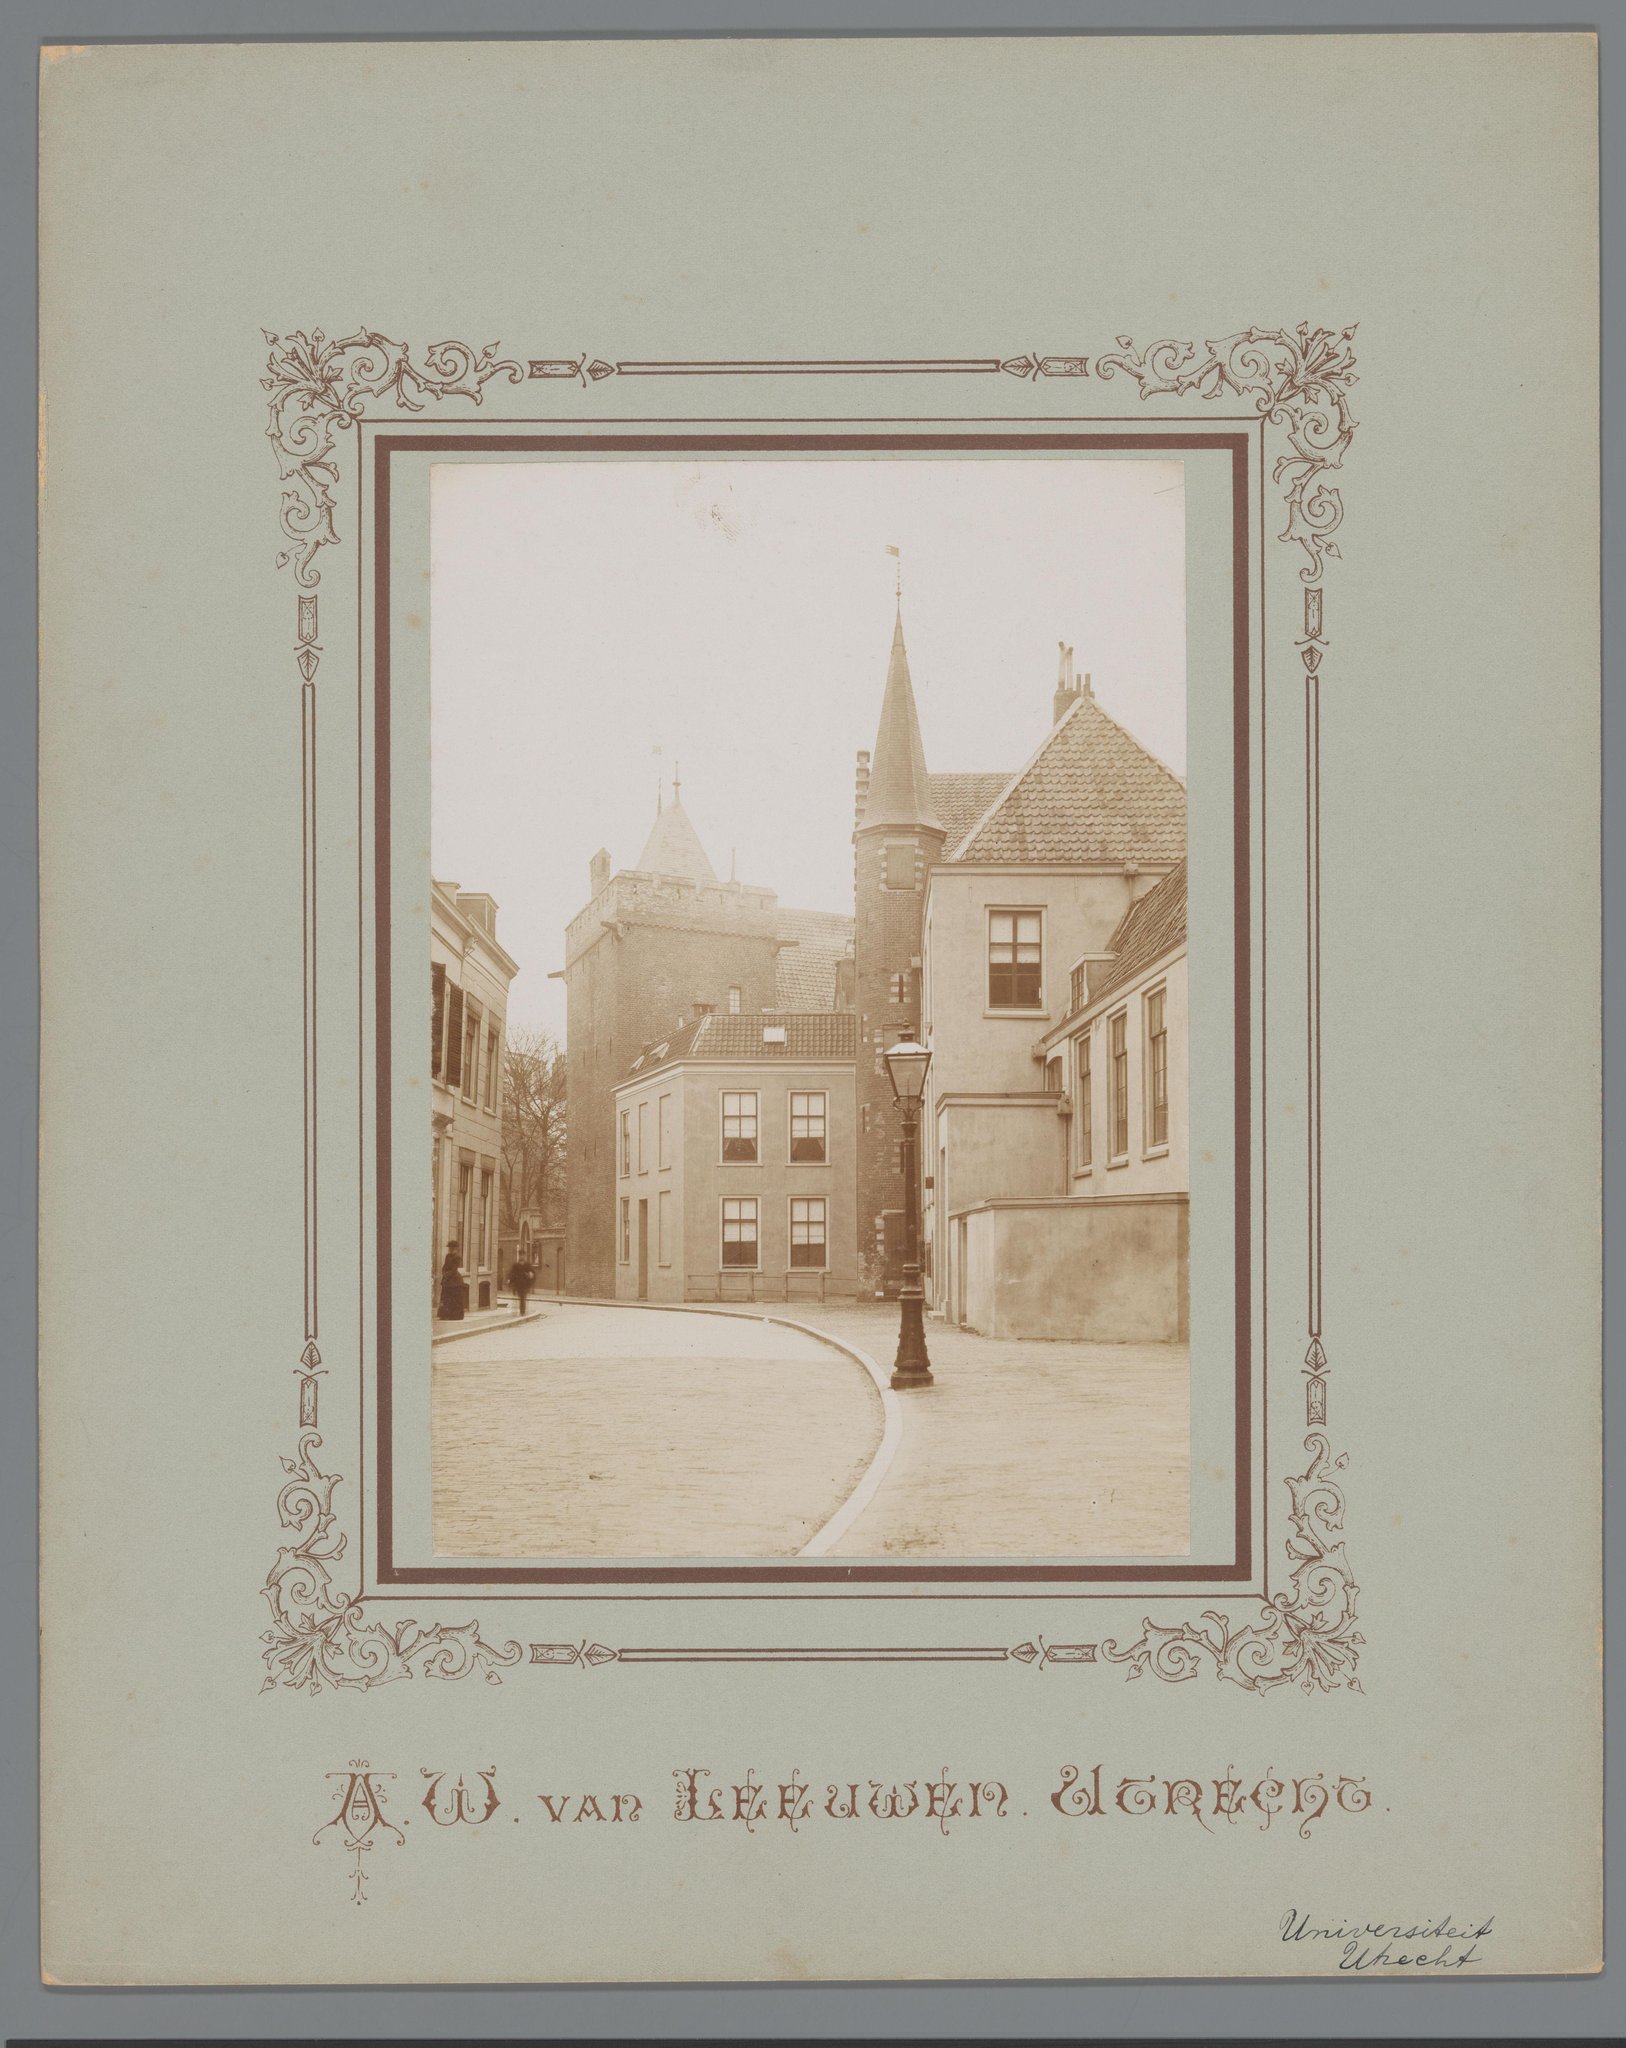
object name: photograph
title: Straatgezicht, vermoedelijk met de Universiteit van Utrecht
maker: a.w. van leeuwen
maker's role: fotograaf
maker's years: 1868-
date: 1890-1909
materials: cardboard, photographic support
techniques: collodion silver print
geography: utrecht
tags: university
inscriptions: collector's mark: Lugt 2228, annotation: ‘Universiteit/ Utrecht’, inscription: ‘A.W. van Leeuwen. Utrecht’, annotation: ‘Oude academie’, number: ‘09' 79’, retailer's mark: ‘G. Hilhorst A zn/ Acad boek en kunsthandel/ Algem. Muziekh./ Domsteeg F.1/ Utrecht’